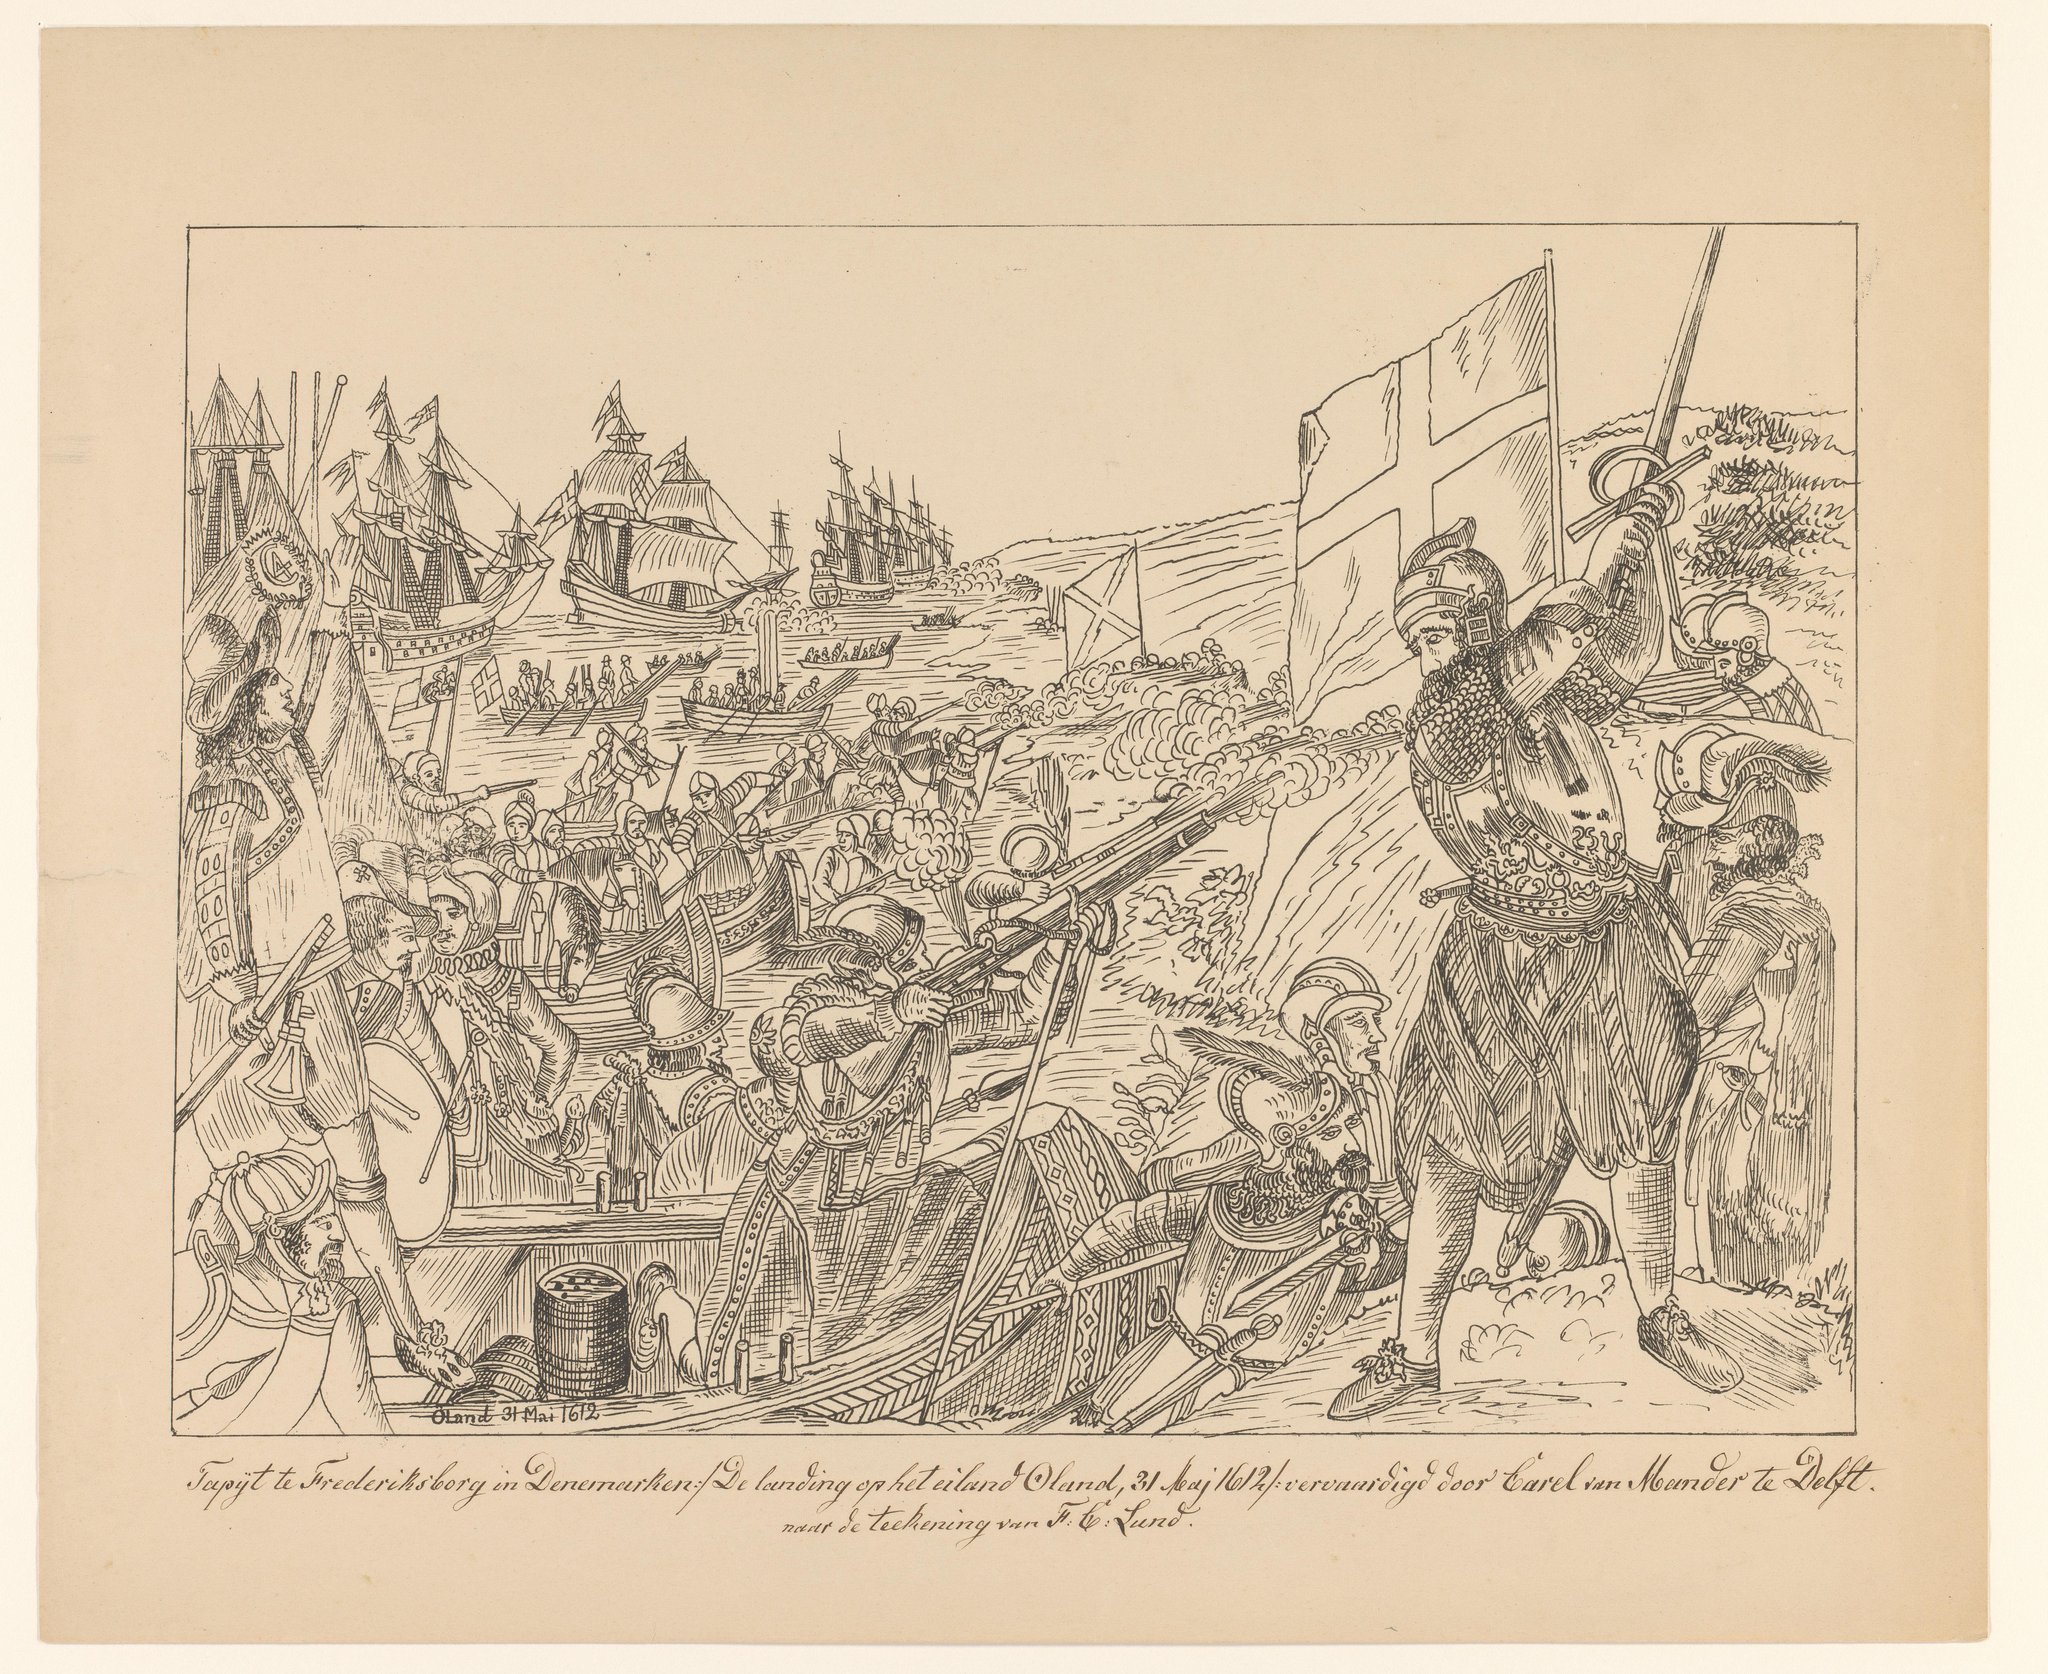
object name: print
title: Landing op het eiland Oland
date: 1845-1908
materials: paper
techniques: lithograph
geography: netherlands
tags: warfare; military affairs (+ during the battle), fighting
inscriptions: date: ‘Oland 31 Mai 1612’, inscription: ‘Tapijt te Frederiksborg in Denemarken : / De landing op het eiland Oland, 31 Mai 1612 /: vervaardigd door Carel van Mander te Delft. naar de tekening van F.C. Lund.’, collector's mark: Lugt 2228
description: Studie van een tapijt dat in 1859 verloren is gegaan en oorspronkelijk bestemd was voor kasteel Frederiksborg. Op het tapijt is de landing op het eiland Oland op 31 mei 1612 te zien. Karel van Mander maakte het ontwerp voor het tapijt, Heinrich Hansen maakte een tekening naar het tapijt en een onbekende lithograaf maakte naar de tekening deze lithografie.